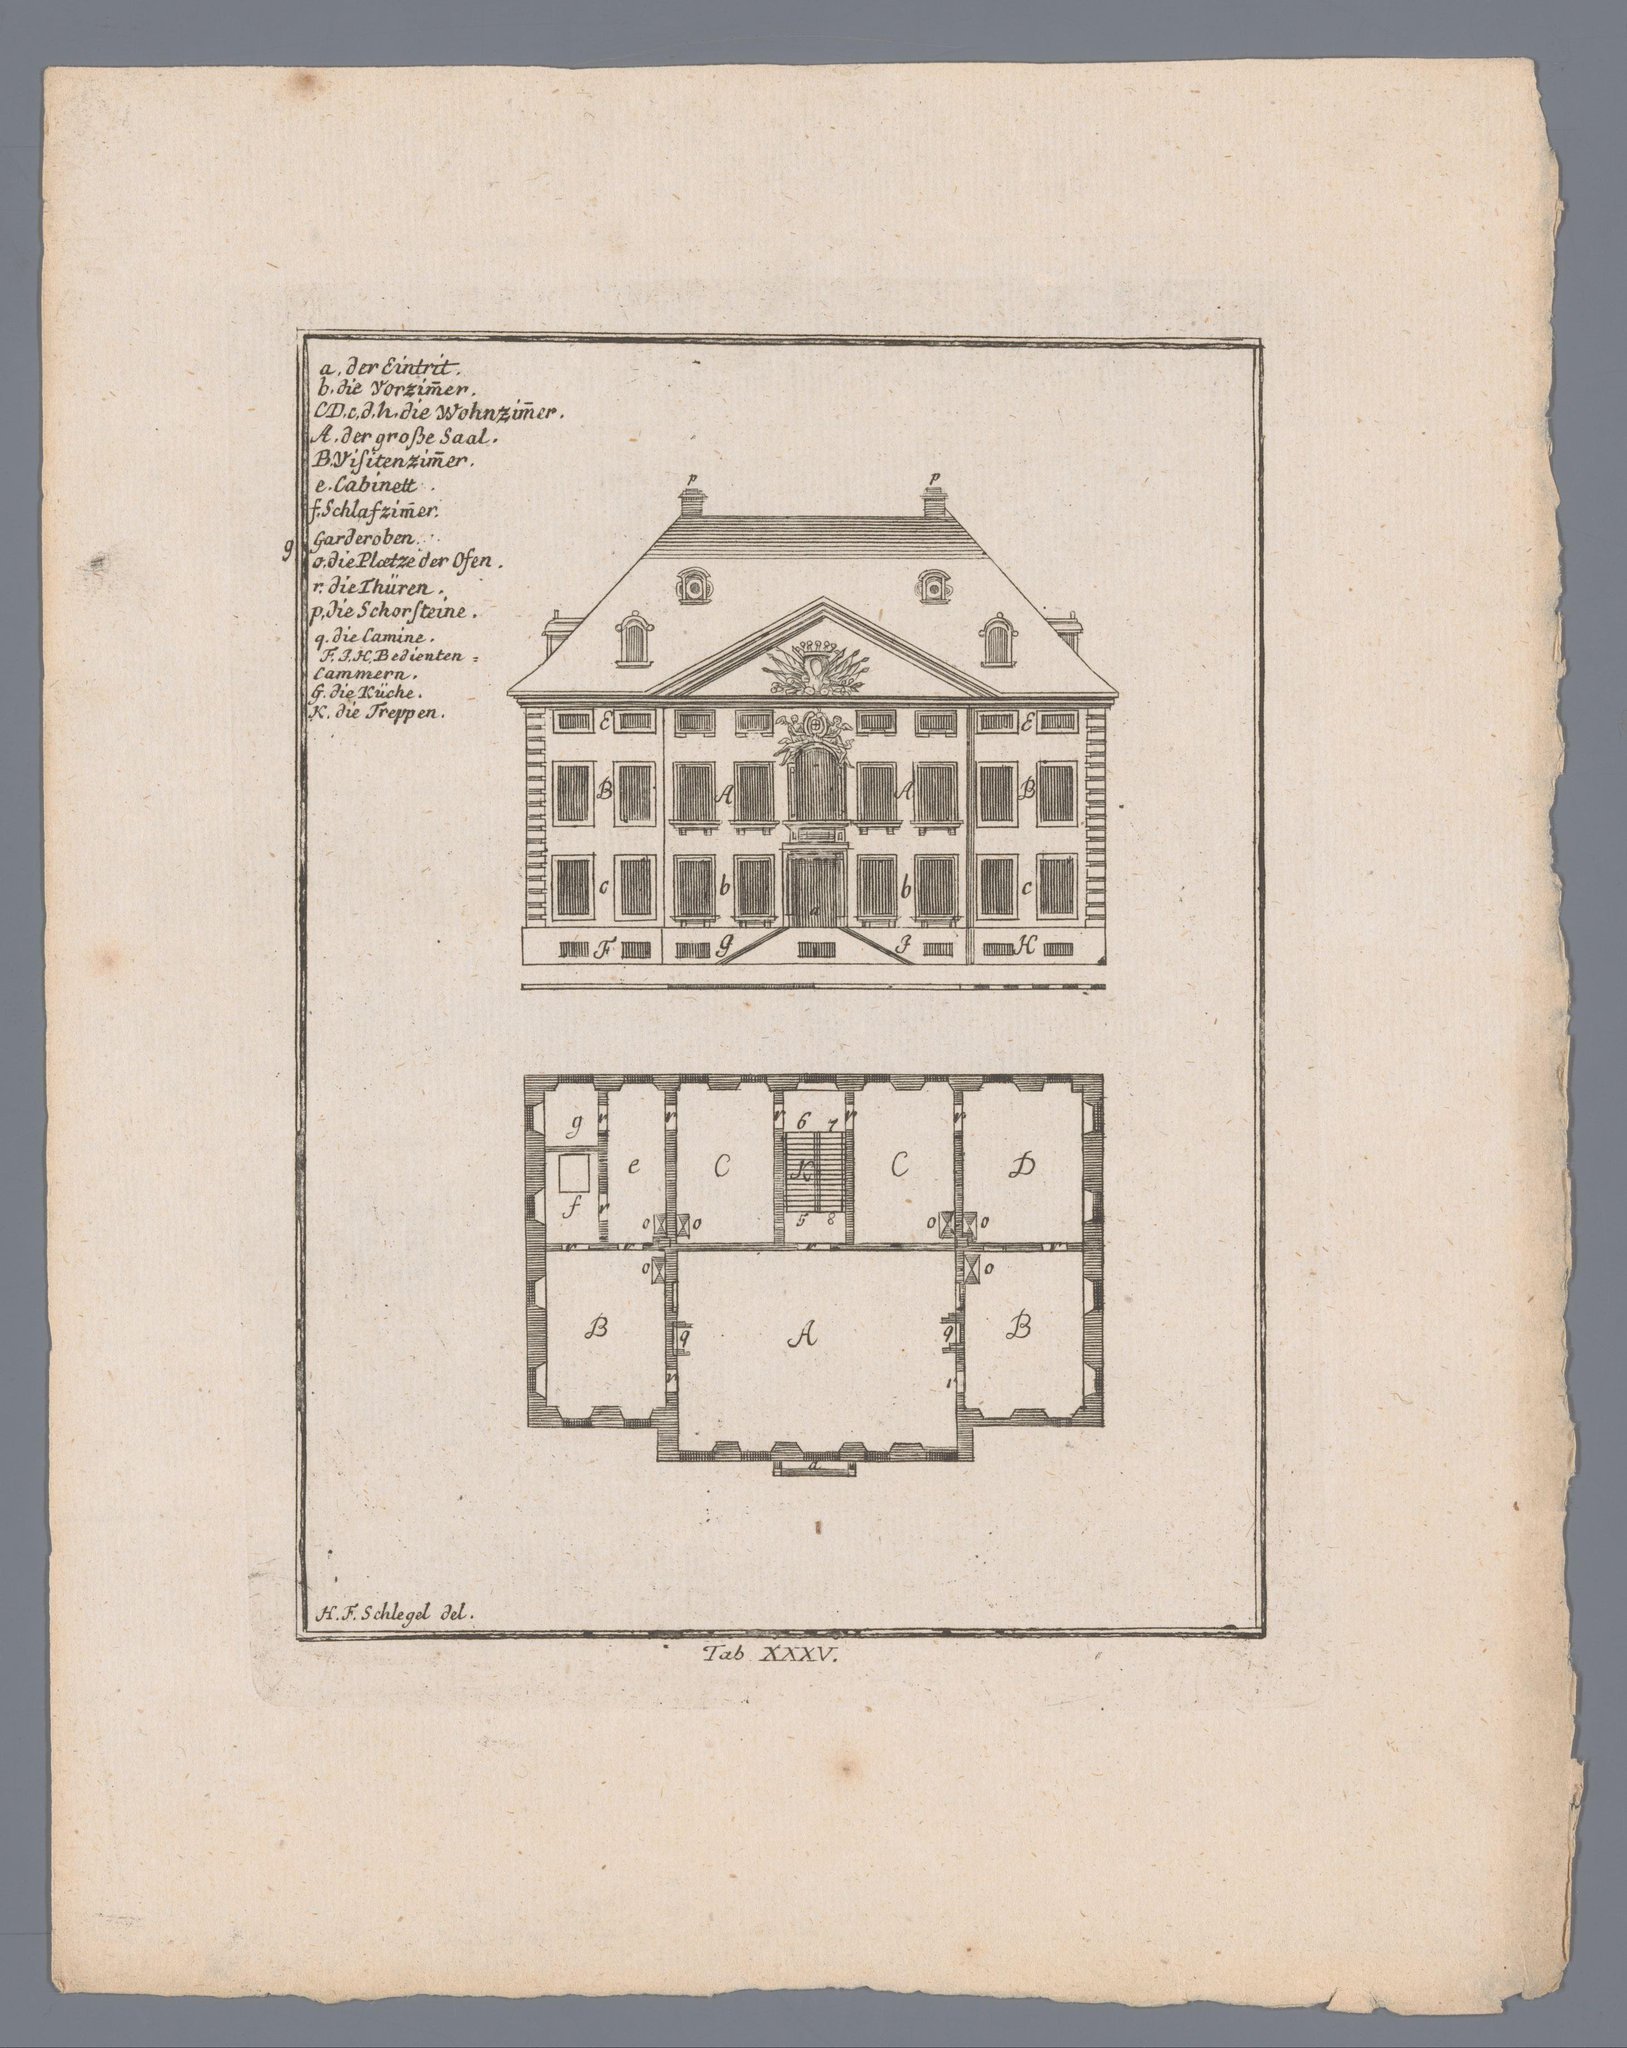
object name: print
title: Opstand en plattegrond van een herenhuis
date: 1774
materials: paper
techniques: etching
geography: germany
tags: architectural design or model, façade (of house or building)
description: Prent ook gebruikt in: Basedow, Johann Bernhard. Das Basedowische Elementarwerk. Ein Vorrath der besten Erkenntnisse zum Lernen, Lehren, Wiederholen und Nachdenken. Leipzig: Siegfried Lebrecht Crucius, 1774.